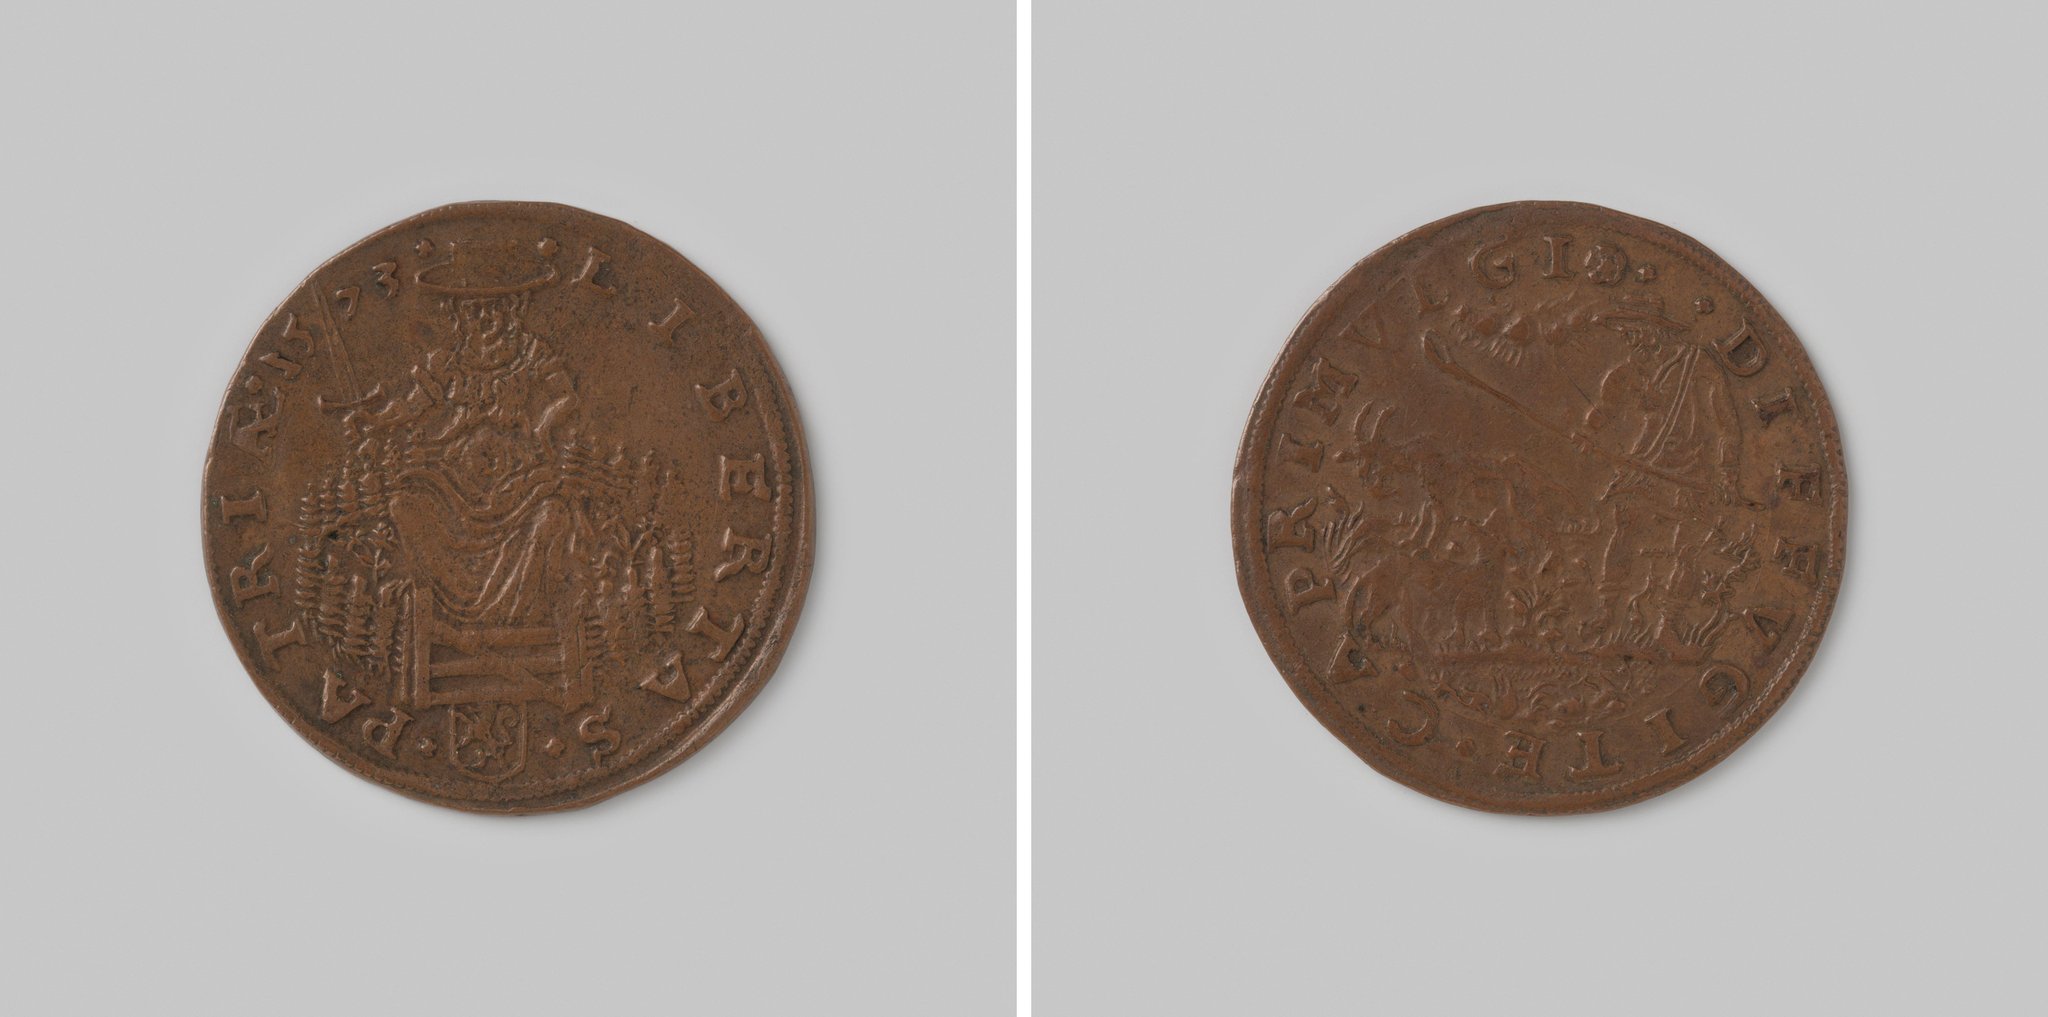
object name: jeton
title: Rekenpenning uit Dordrecht op het vertrek van Alva uit de Nederlanden 1573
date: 1573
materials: copper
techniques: striking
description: Koperen penning, op de voorzijde de Hollandse Maagd met vrijheidshoed en zwaard in een tuin, met omschrift, op de keerzijde een herder die een vos bij zijn geit verjaagt, onder het hemellicht, met omschrift.